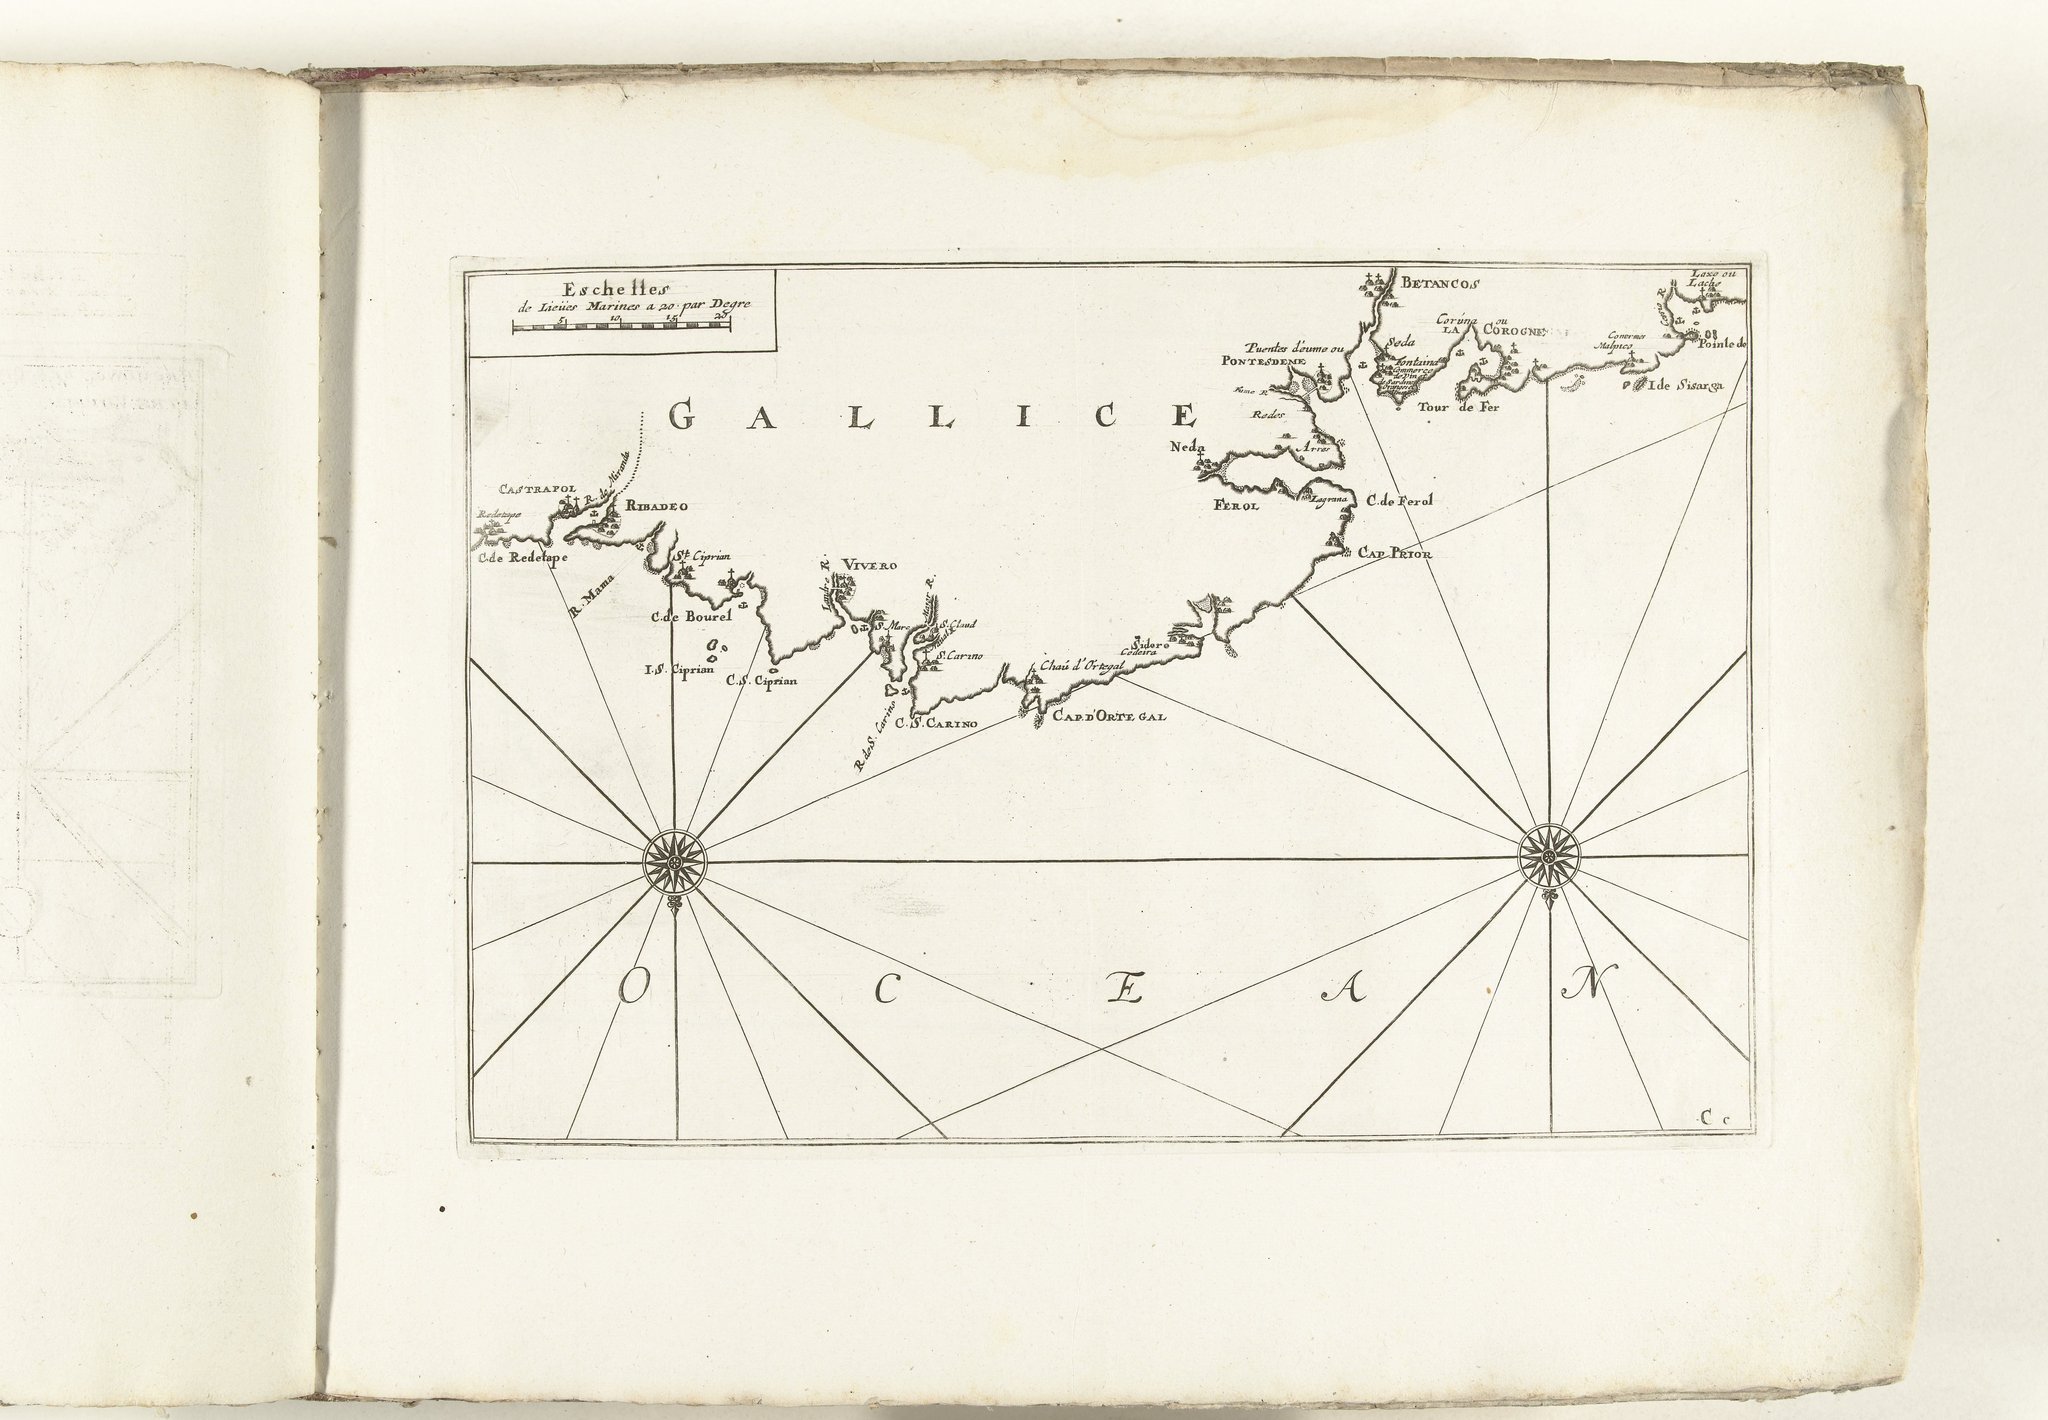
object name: map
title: Les Forces de l'Europe, Asie, Afrique et Amerique, ou description des principales villes avec leurs fortifications. Dessignées par les meilleurs ingenieurs, particulierement celles qui sont sous la domination de la France (...) et ornées de plusieurs superbes edifices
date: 1702-1703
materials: paper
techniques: engraving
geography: amsterdam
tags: maps of separate countries or regions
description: Kaart van de noordkust van Galicië. Gemerkt rechtsonder: Cc. Onderdeel van het tweede van twee delen van het prentwerk: Les costes de France et d'Espagne (oftewel deel 14 van: Les Forces de l'Europe, Asie, Afrique et Amerique), uitgegeven ca. 1702. Het prentwerk bestaat in totaal uit 43 gemerkte platen van de kust van Frankrijk en Spanje, in het kader van de Spaanse Successieoorlog. Deze platen zijn gekopieerd naar anonieme Franse platen oorspronkelijk uitgegeven door Nicolas de Fer te Parijs. Titel en opschriften in de plaat in het Frans.